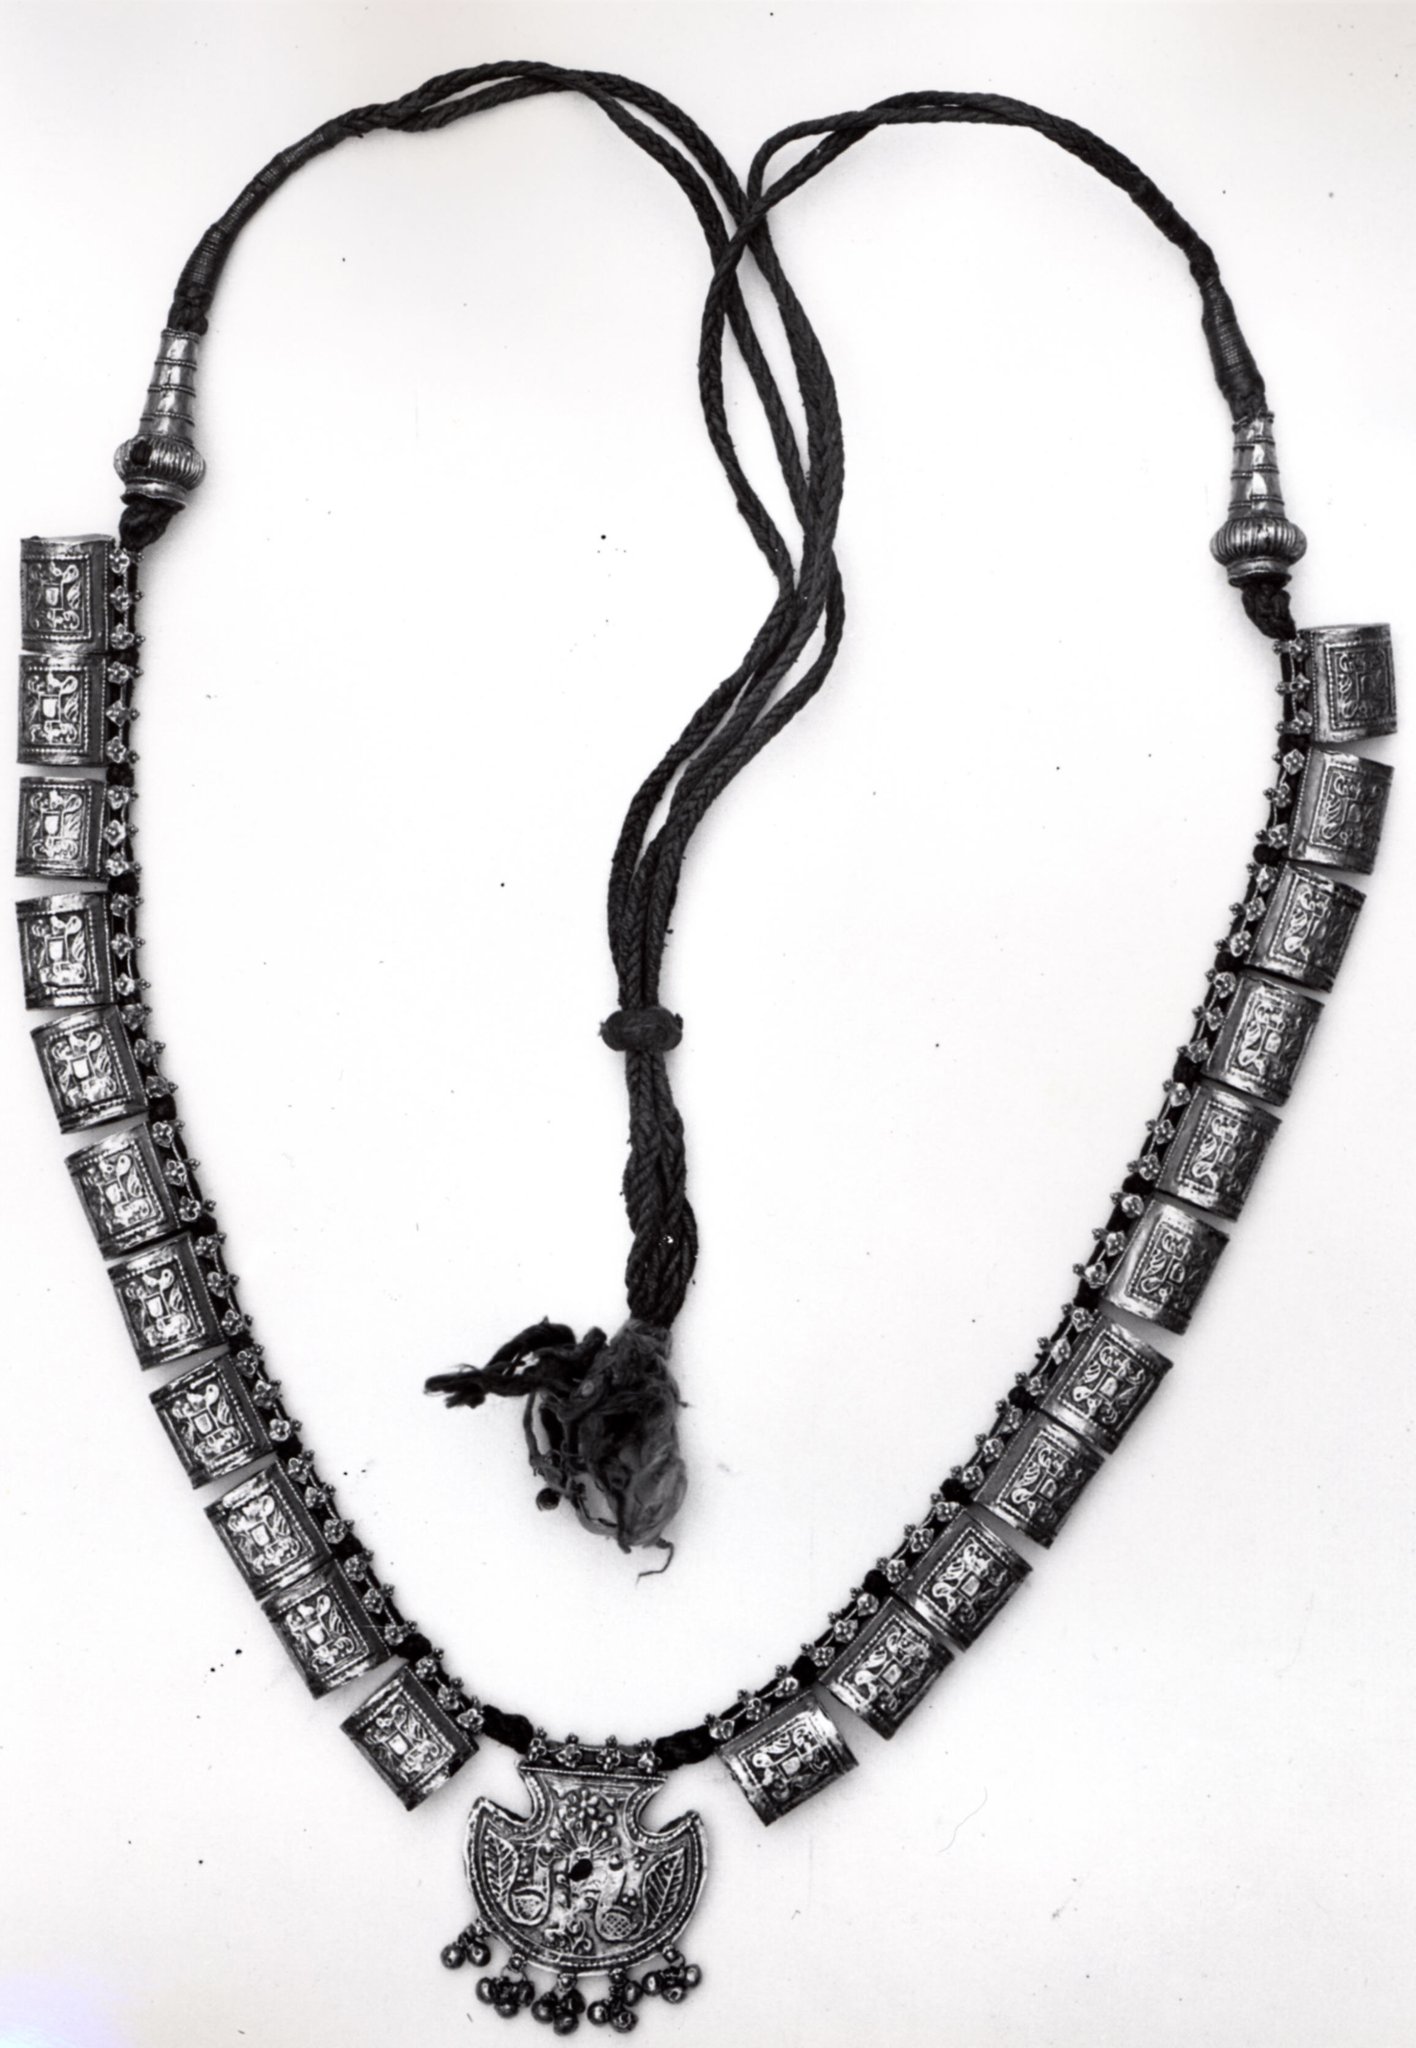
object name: necklace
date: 1701-1900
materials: gold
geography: india